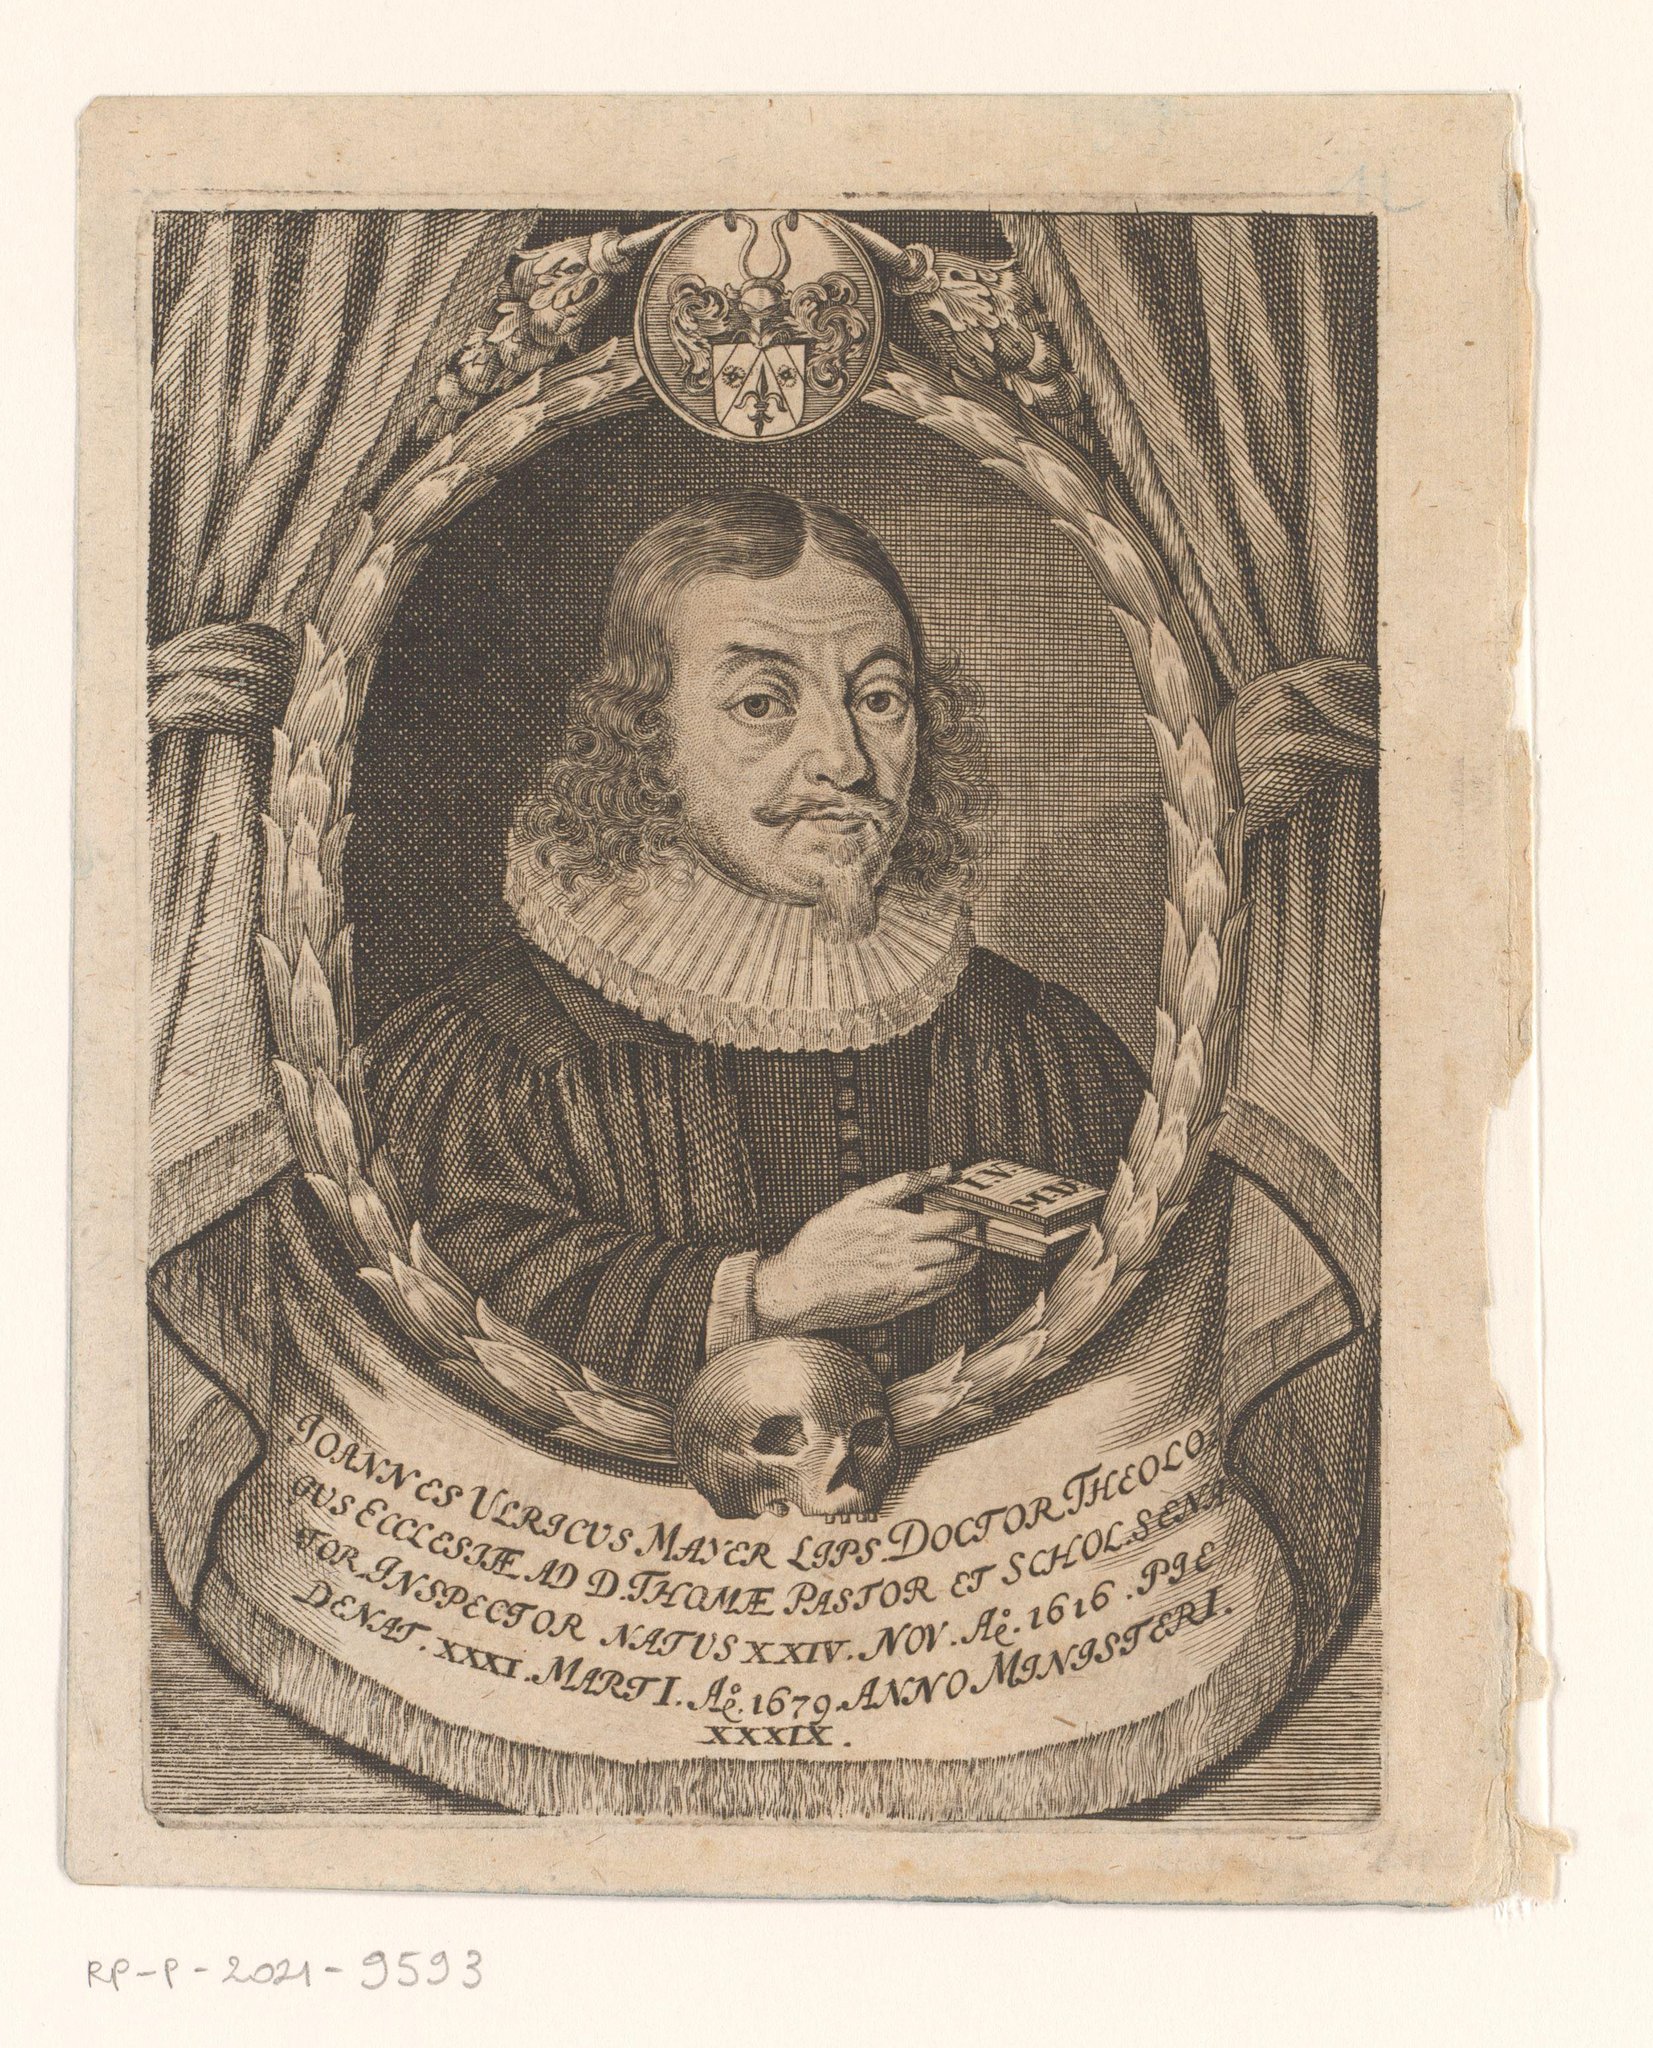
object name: print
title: Portret van Johann Ulrich Mayer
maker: Anonymous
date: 1679-1729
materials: paper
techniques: engraving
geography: germany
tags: theologian, historical persons, book, skull as symbol of 'vanitas', armorial bearing, heraldry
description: Met vierregelig onderschrift in het Latijn.